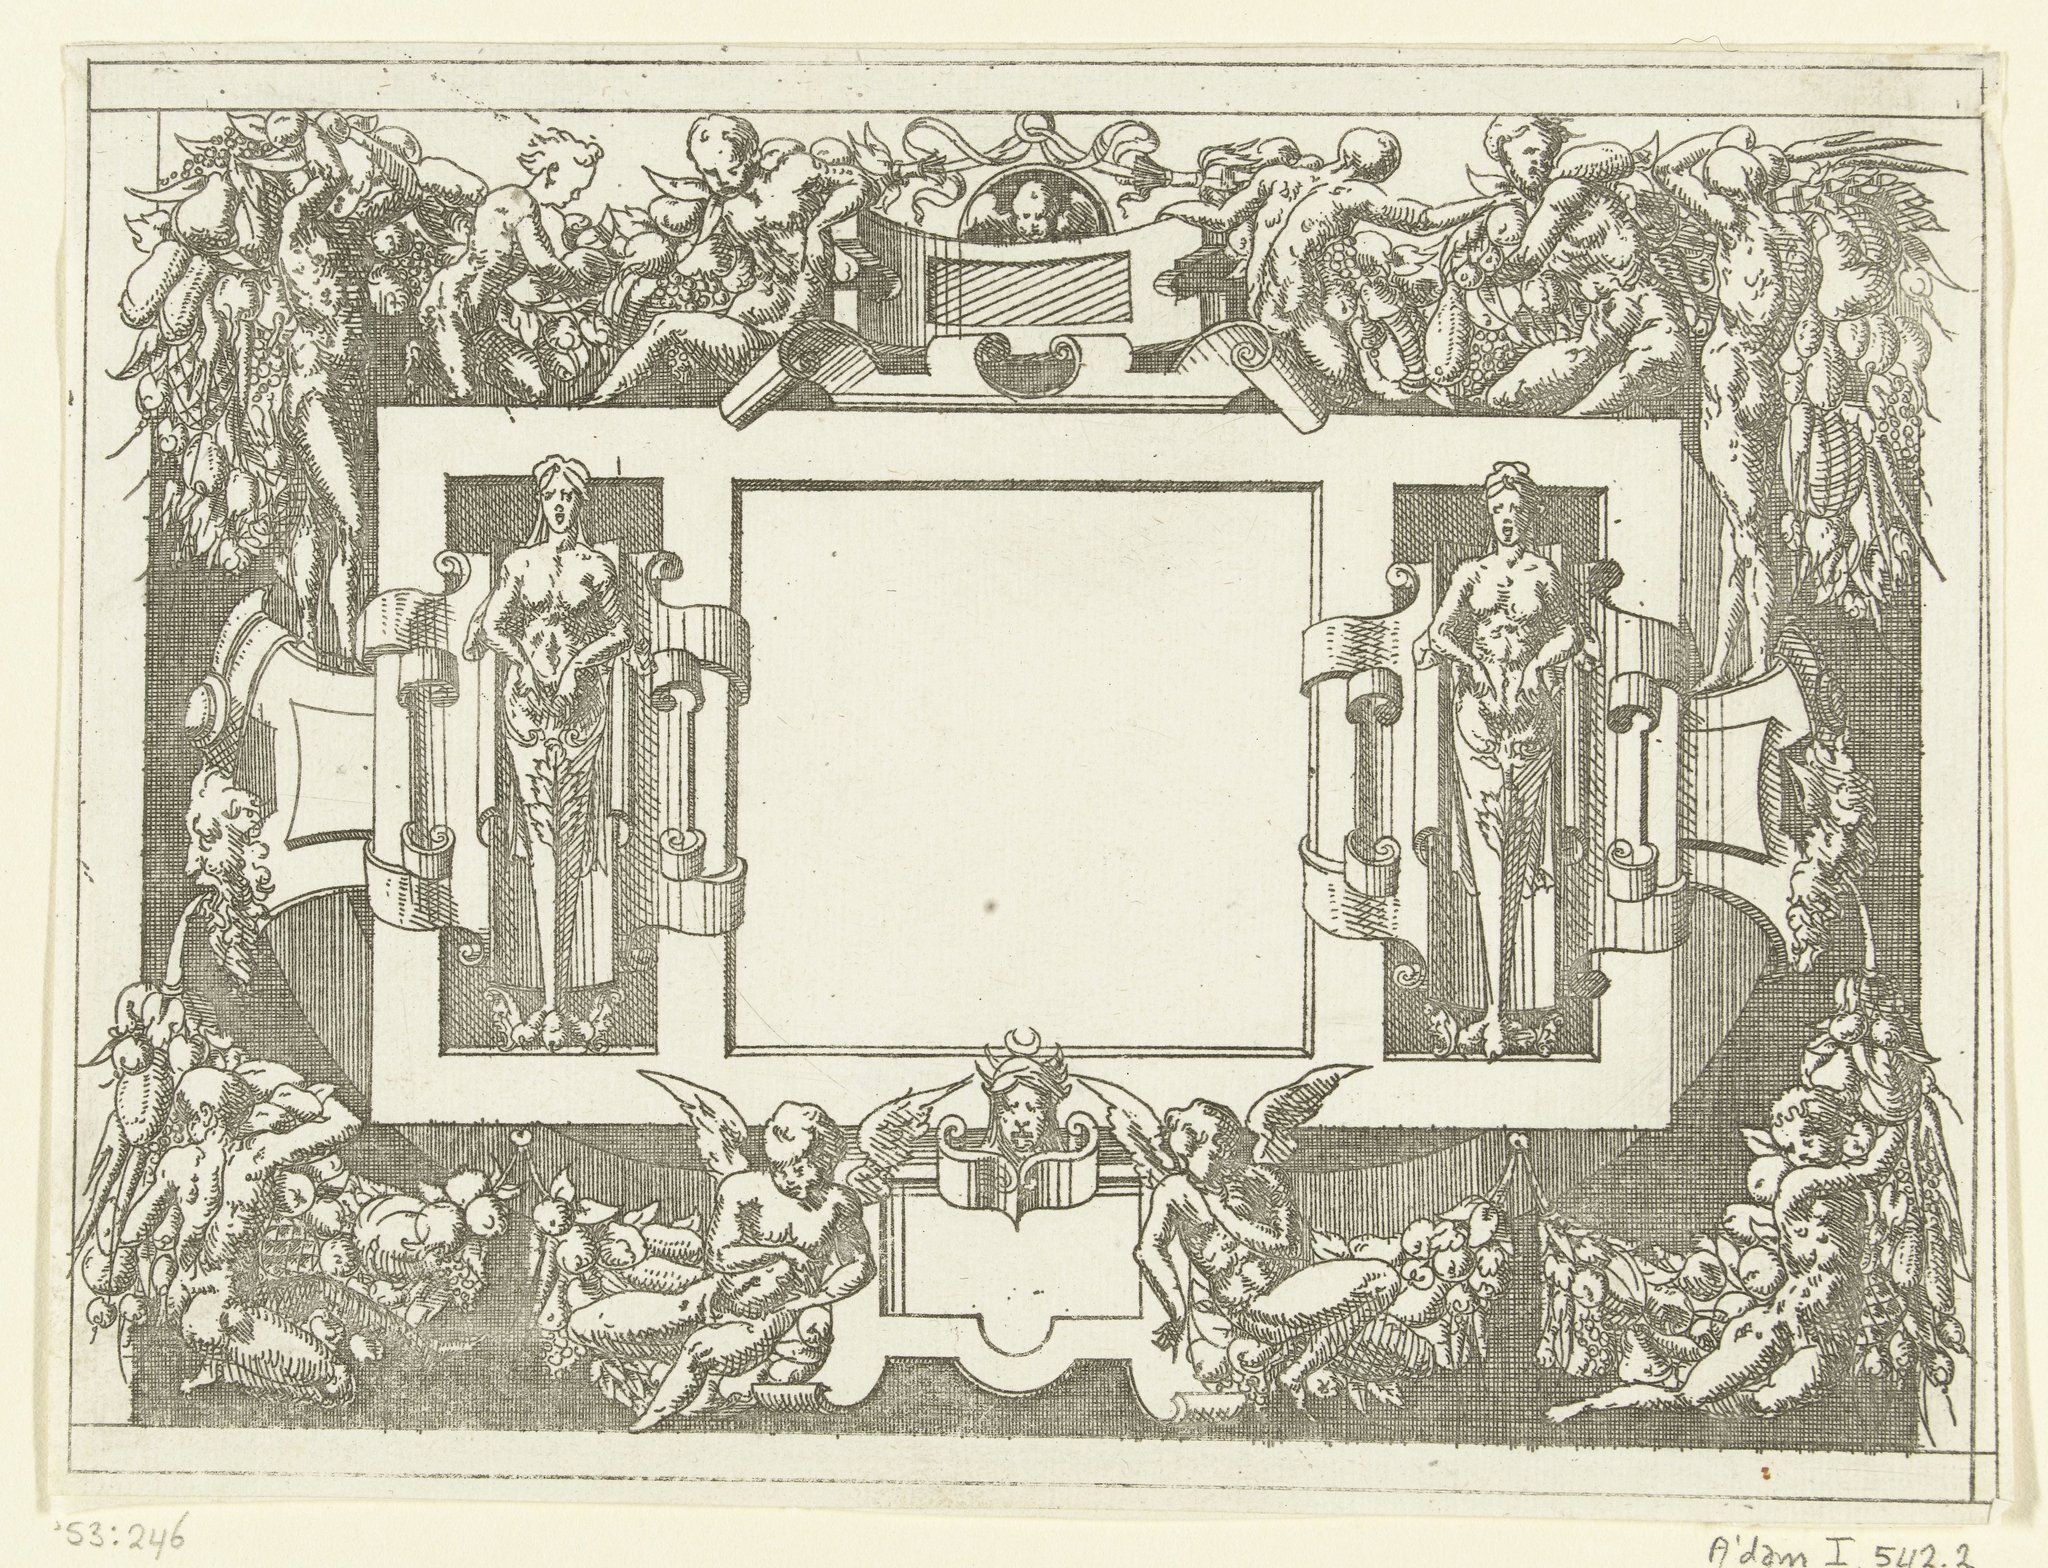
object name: print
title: Kleine cartouche naar voorbeeld te Fontainebleau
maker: Anonymous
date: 1520-1584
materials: paper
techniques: etching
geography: france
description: Langs de bovenrand hangen guirlandes van vruchten, opgehouden door zes figuren. Uit serie van 32 bladen. De cartouches zijn deels ontleend aan de prenten van Antonio Fantuzzi naar de decoratie van de Galerie van François 1er door Giovanni Battista Rosso. De serie staat ook bekend onder de titel Petits cartouches de Fontainebleau.